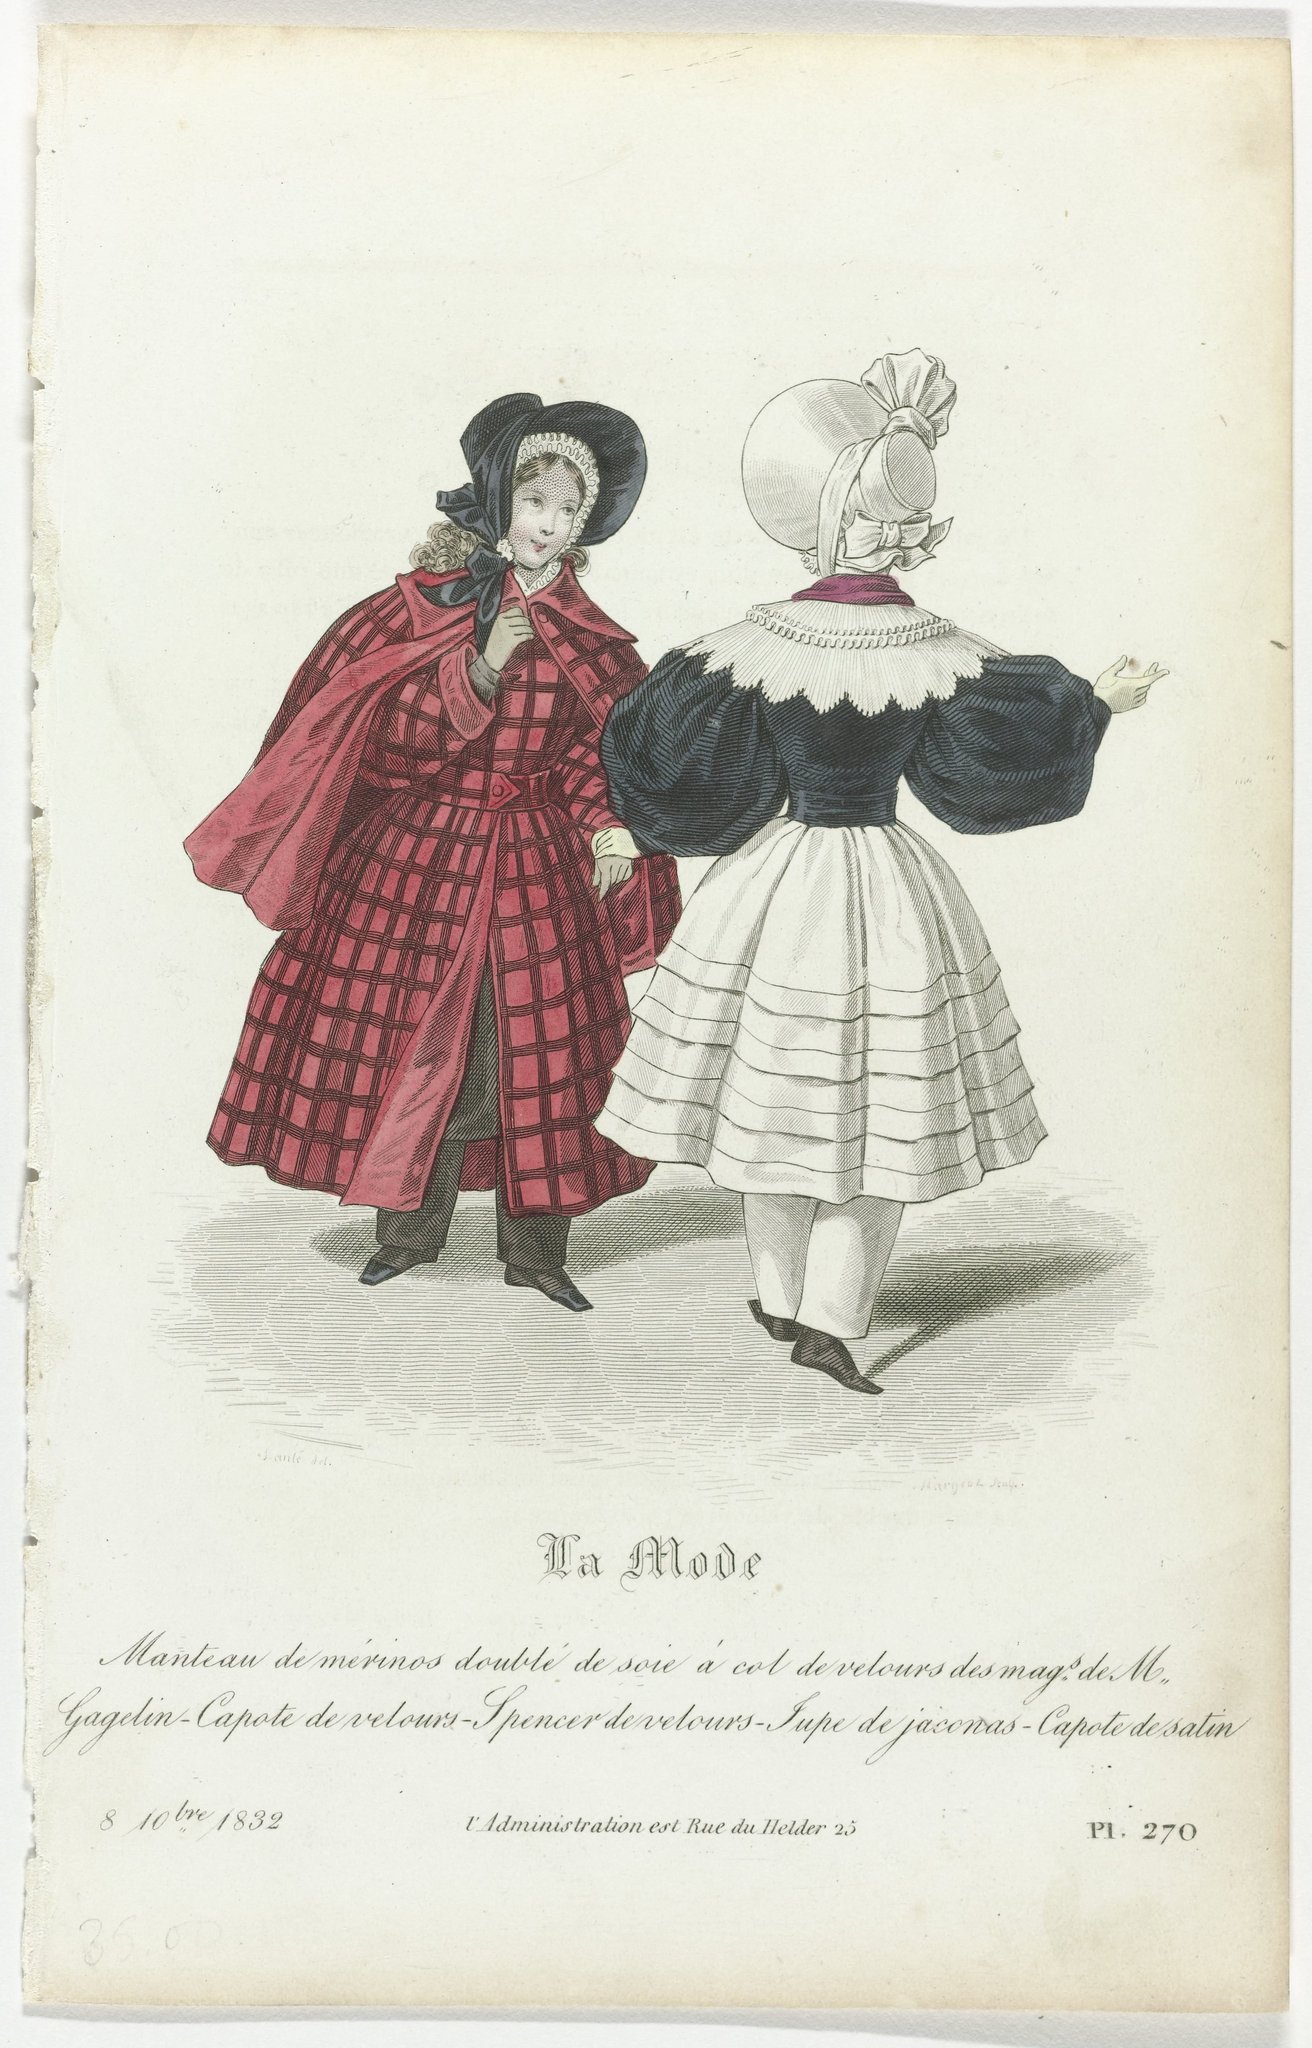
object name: fashion print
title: La Mode, 8 octobre 1832, Pl. 270 : Manteau de mérinos (...)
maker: Anonymous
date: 1832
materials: paper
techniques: engraving, hand coloring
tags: underclothes for the lower part of the body: bloomers (+ girls' clothes), head-gear (capote) (+ girls' clothes), neck-gear: collar (+ girls' clothes), coat (+ girls' clothes), clothing for the upper part of the body (spencer) (+ girls' clothes), fashion plates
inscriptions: caption: ‘Manteau de mérinos doublé de soie á col de velours des mag.s de M.Gagelin - Capote de velours - Spencer de velours - Jupe de jaconas - Capote de satin’, address: ‘L'Administration est Rue du Helder 25’, title: ‘La Mode’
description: Meisje in een mantel van geruite merinowol gevoerd met zijde en een kraag van fluweel, uit de winkels van Gagelin. Capote van fluweel. Meisje, op de rug gezien, in een spencer van fluweel. Rok van 'jaconas'. Capote van satijn. Bloomers. De prent is een kopie naar No 3034, 25 septembre 1832, van het modetijdschrift Journal des Dames et des Modes, Costumes Parisiens.